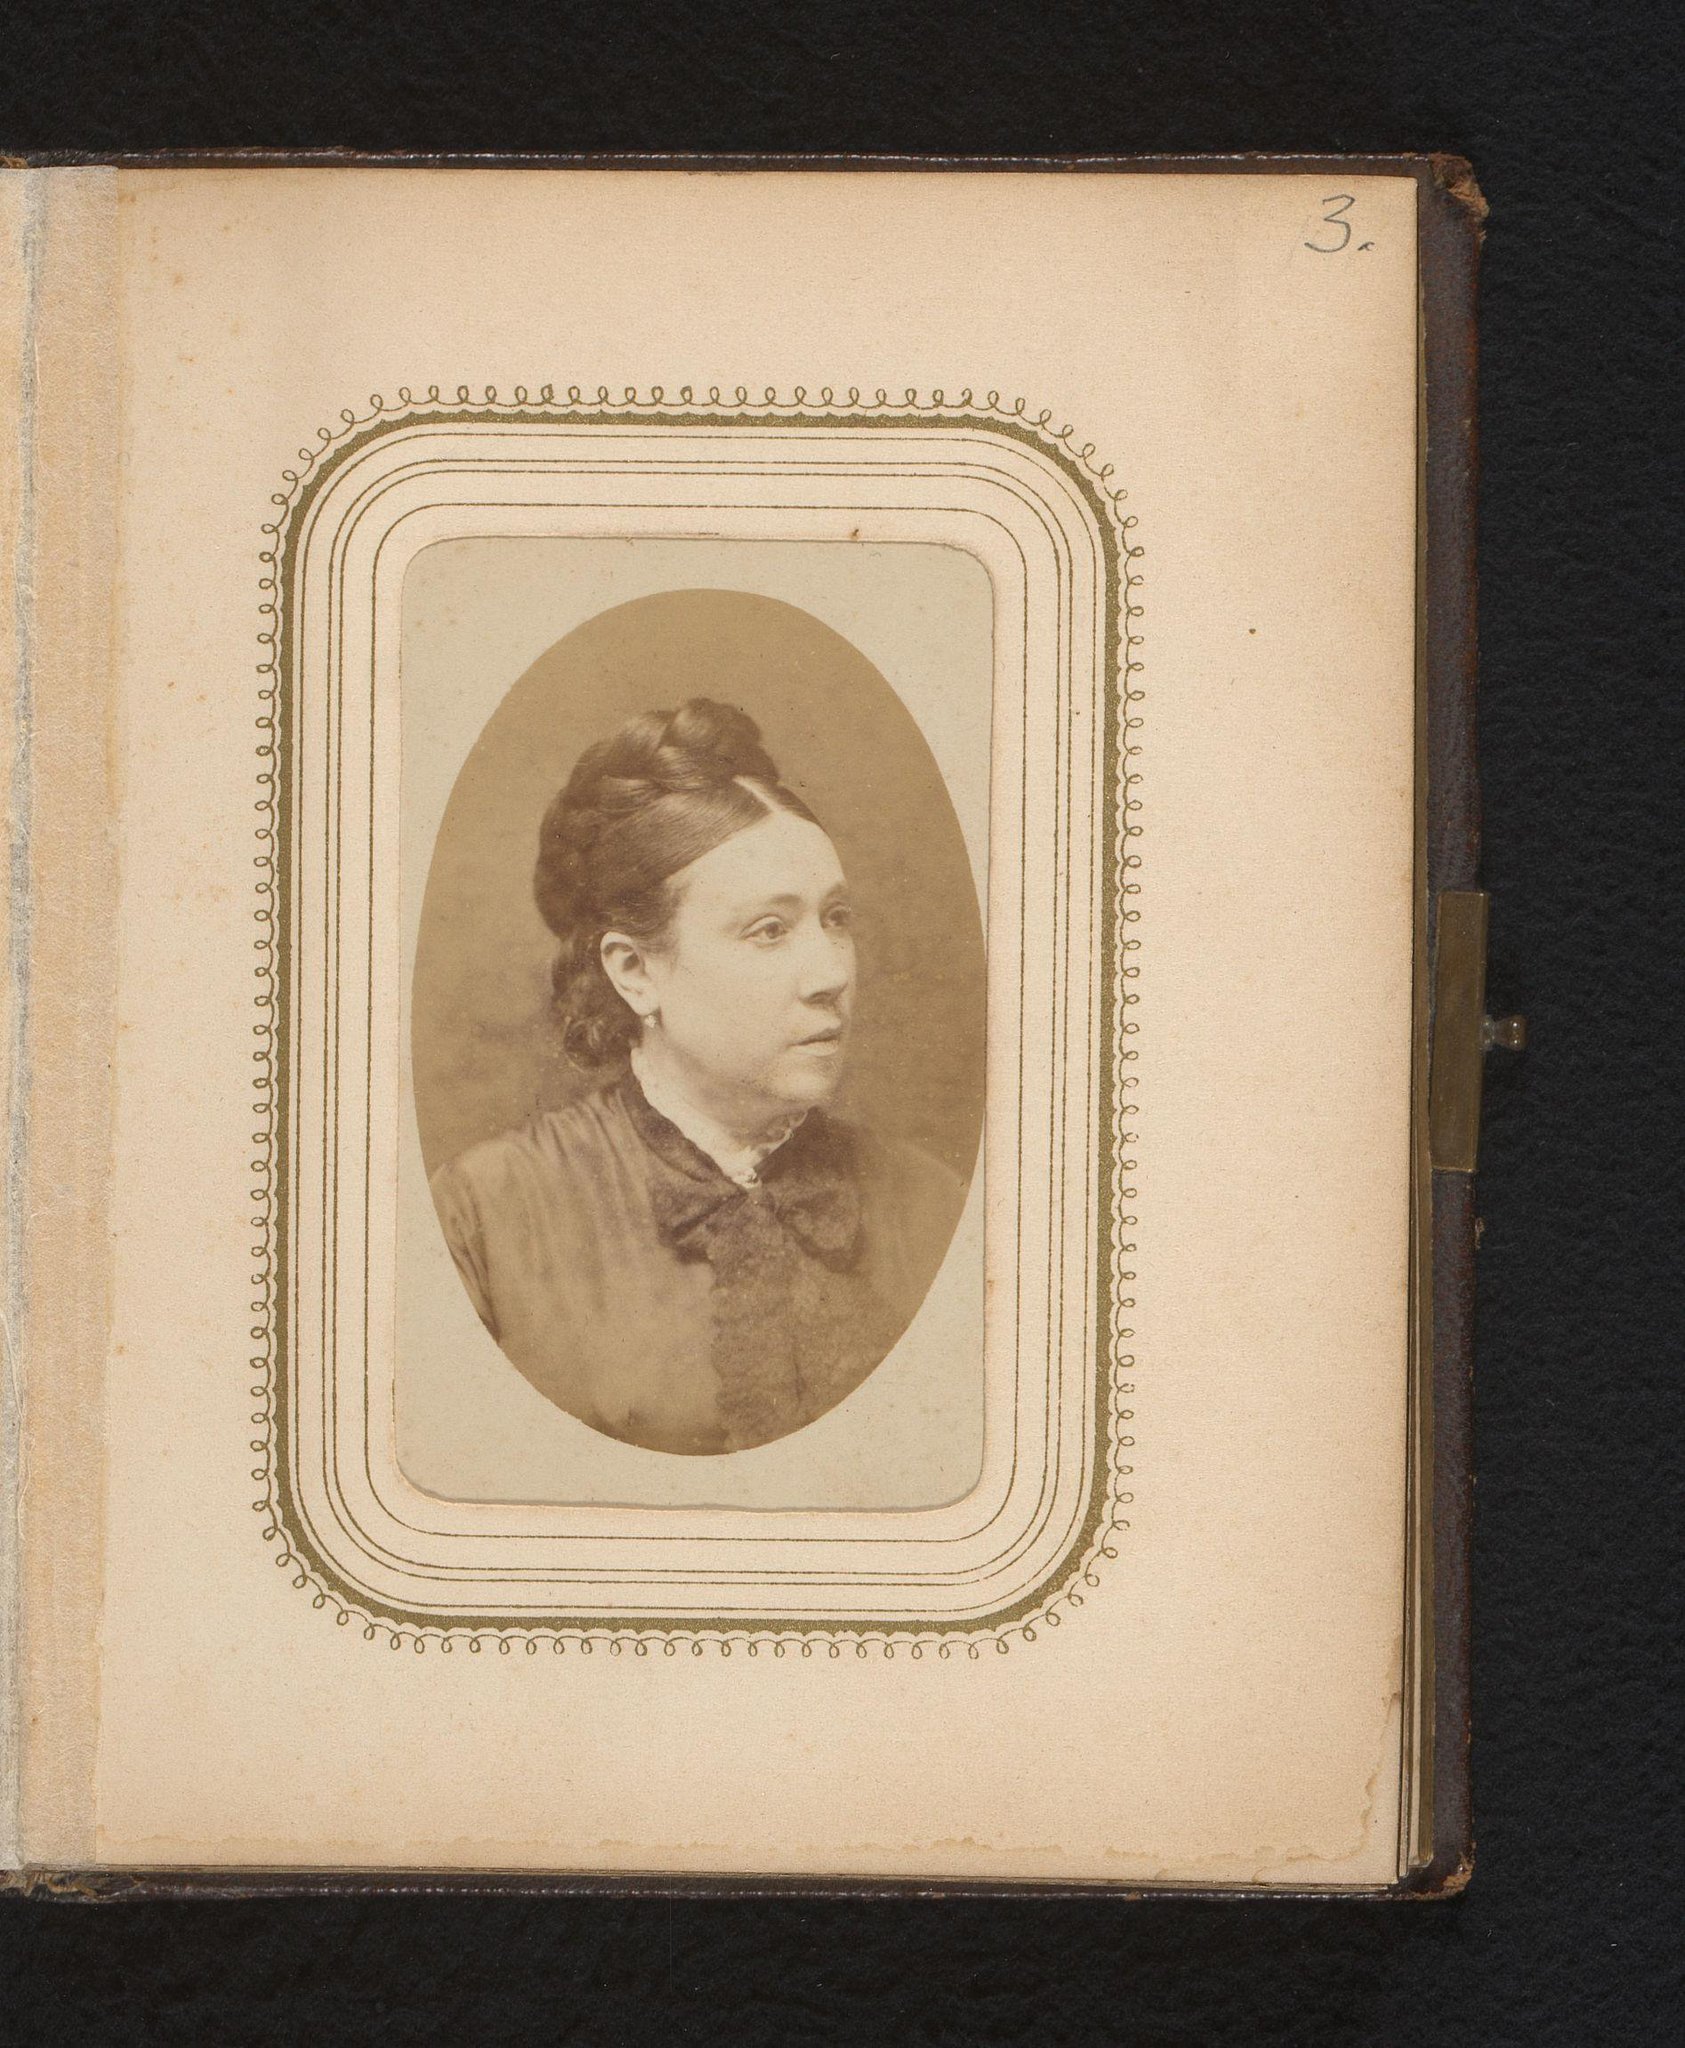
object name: photograph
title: Portret van Wilhelmina Mossel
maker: christian theodor kirch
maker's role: fotograaf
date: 1875-1881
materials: cardboard, paper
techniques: albumen print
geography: amsterdam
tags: utrecht, historical persons - bb - woman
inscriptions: inscription: ‘Photographie/ Chr. Kirch/ Amsterdam/ 179, Kalverstraat over den Heyligenweg.’